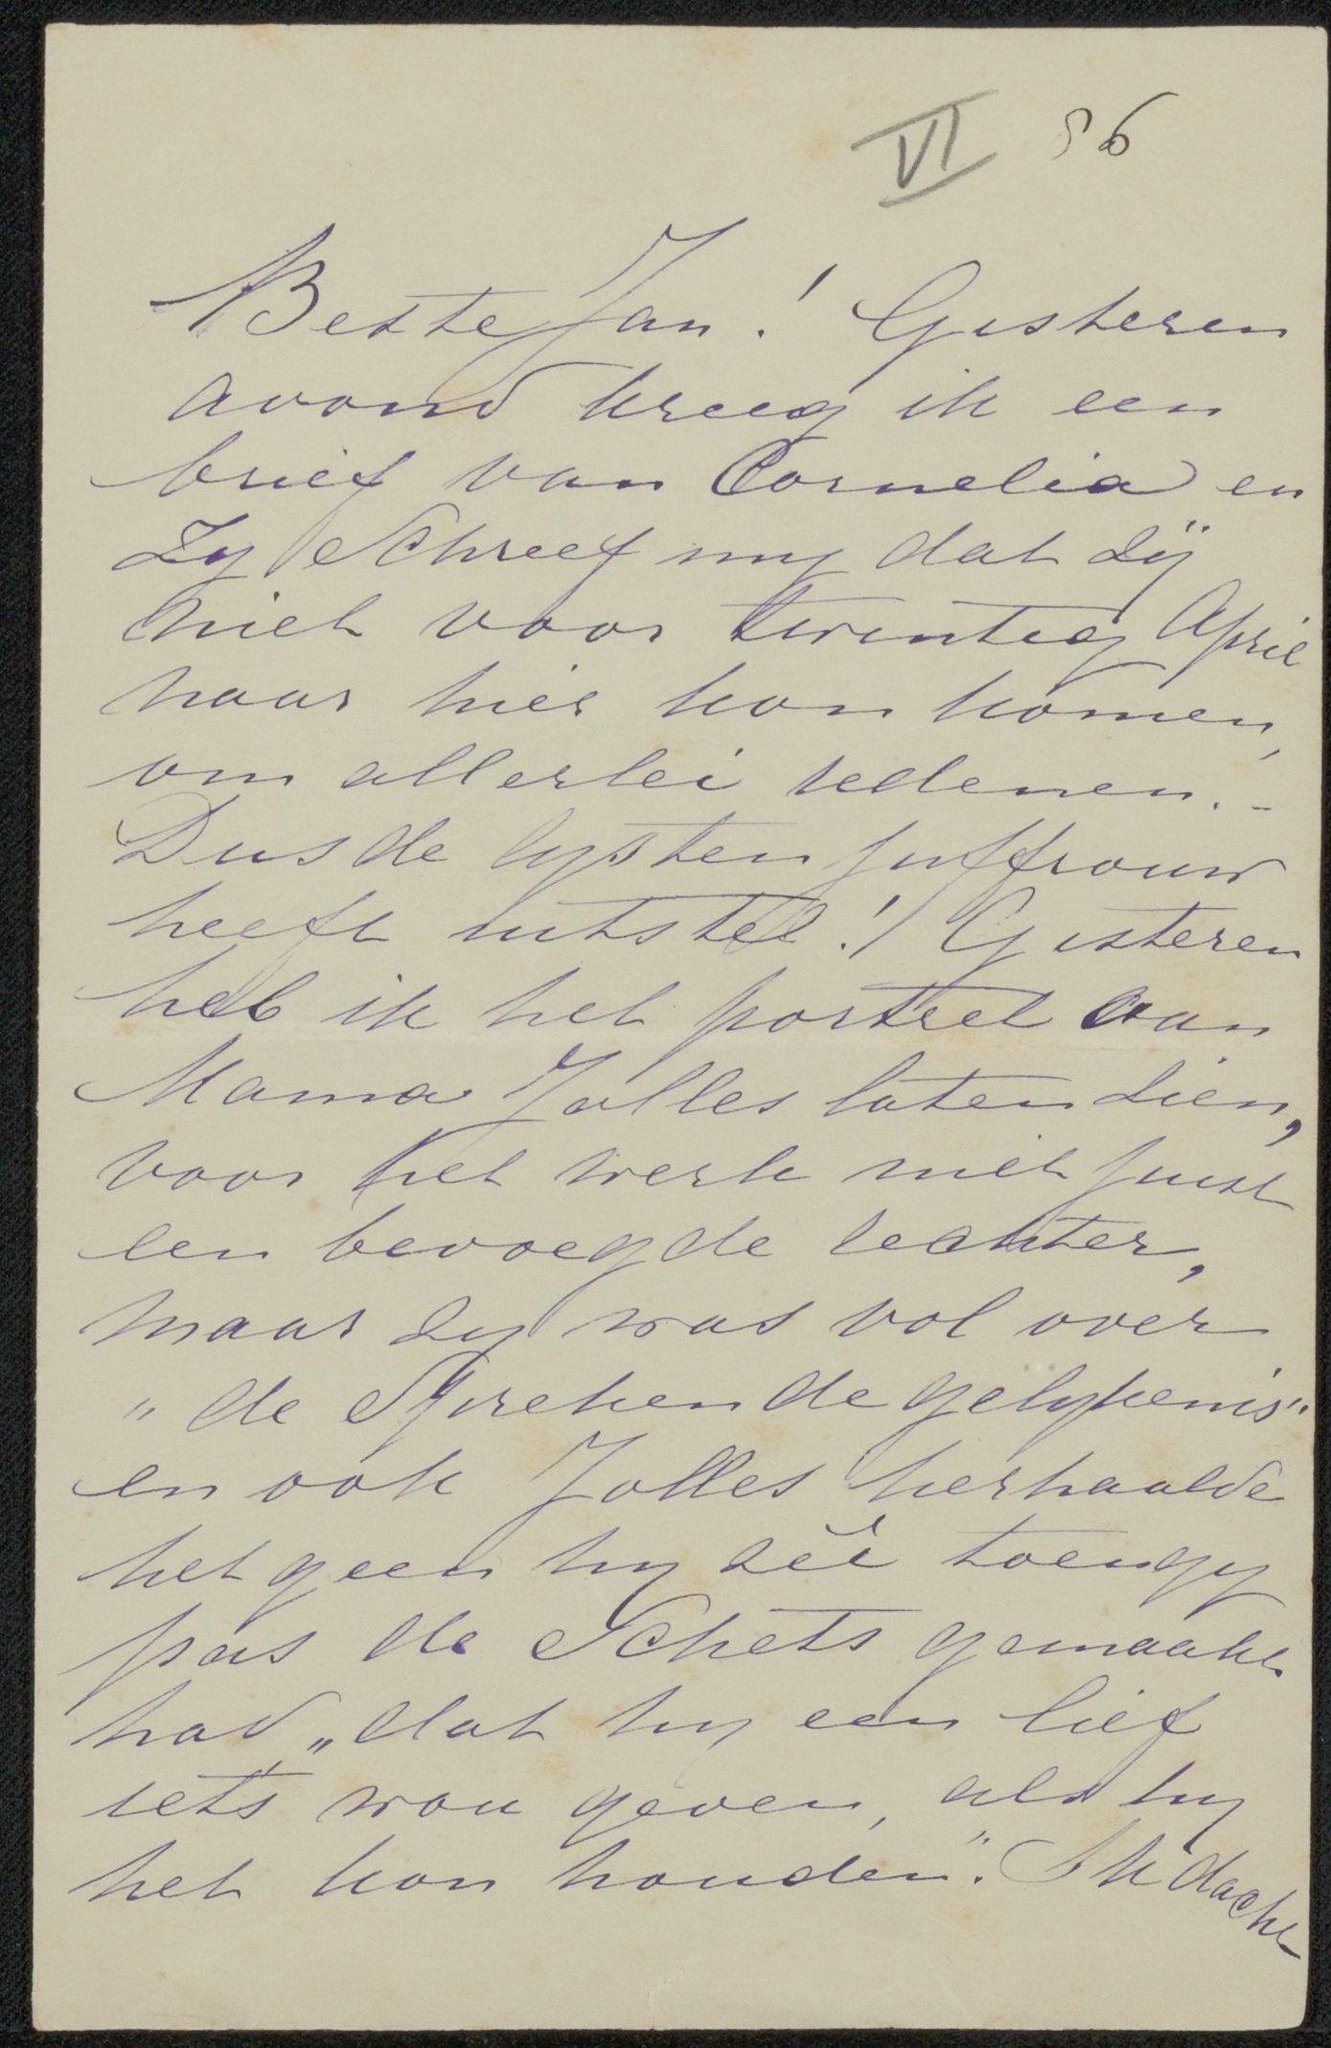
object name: letter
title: Brief aan Jan Veth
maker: jacoba cornelia jolles-singels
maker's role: schrijver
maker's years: 1847-1901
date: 1804-1886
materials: ink, paper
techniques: pen, writing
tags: dordrecht, painter, print maker, draughtsman, designer, jan veth, cornelia johanna veth, historical persons (portraits and scenes from the life)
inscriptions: collector's mark: ‘RPK’